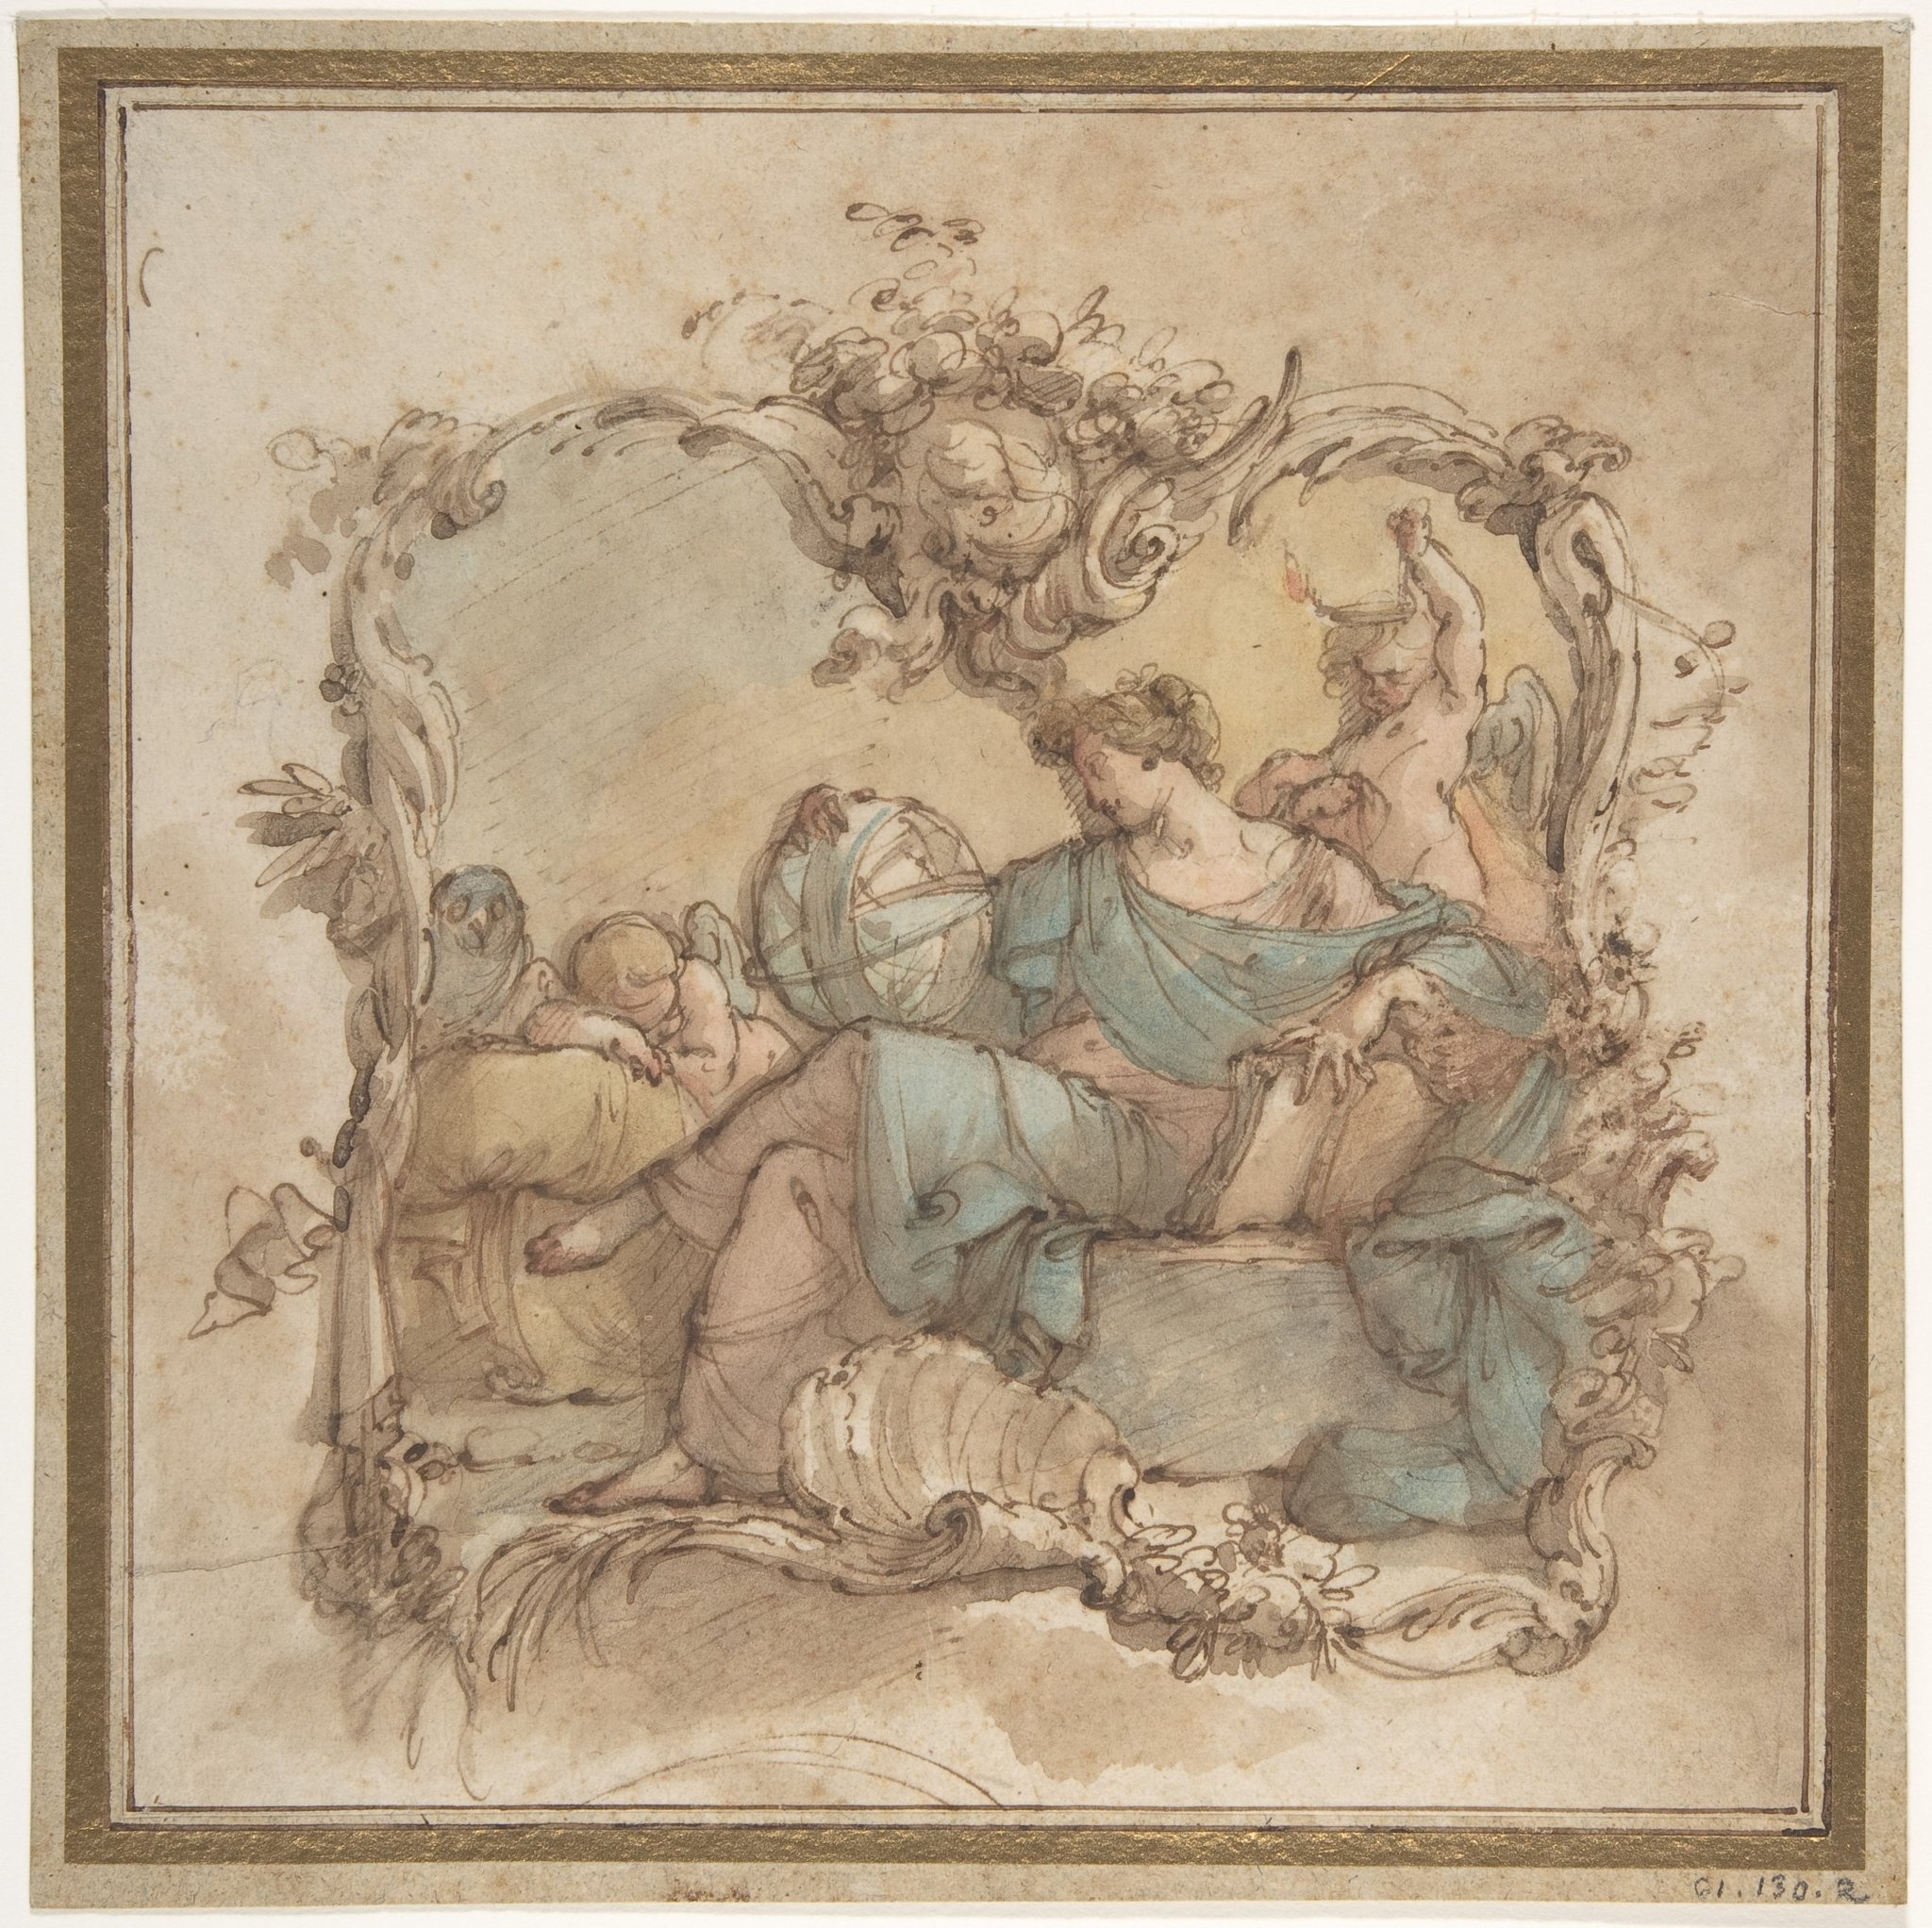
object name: drawing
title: Vignette with an Allegorical Figure of Astronomy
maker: mauro gandolfi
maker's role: artist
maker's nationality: italian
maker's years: 1764-1834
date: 1798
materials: chalk, ink, watercolor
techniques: pen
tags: human figures,astronomy